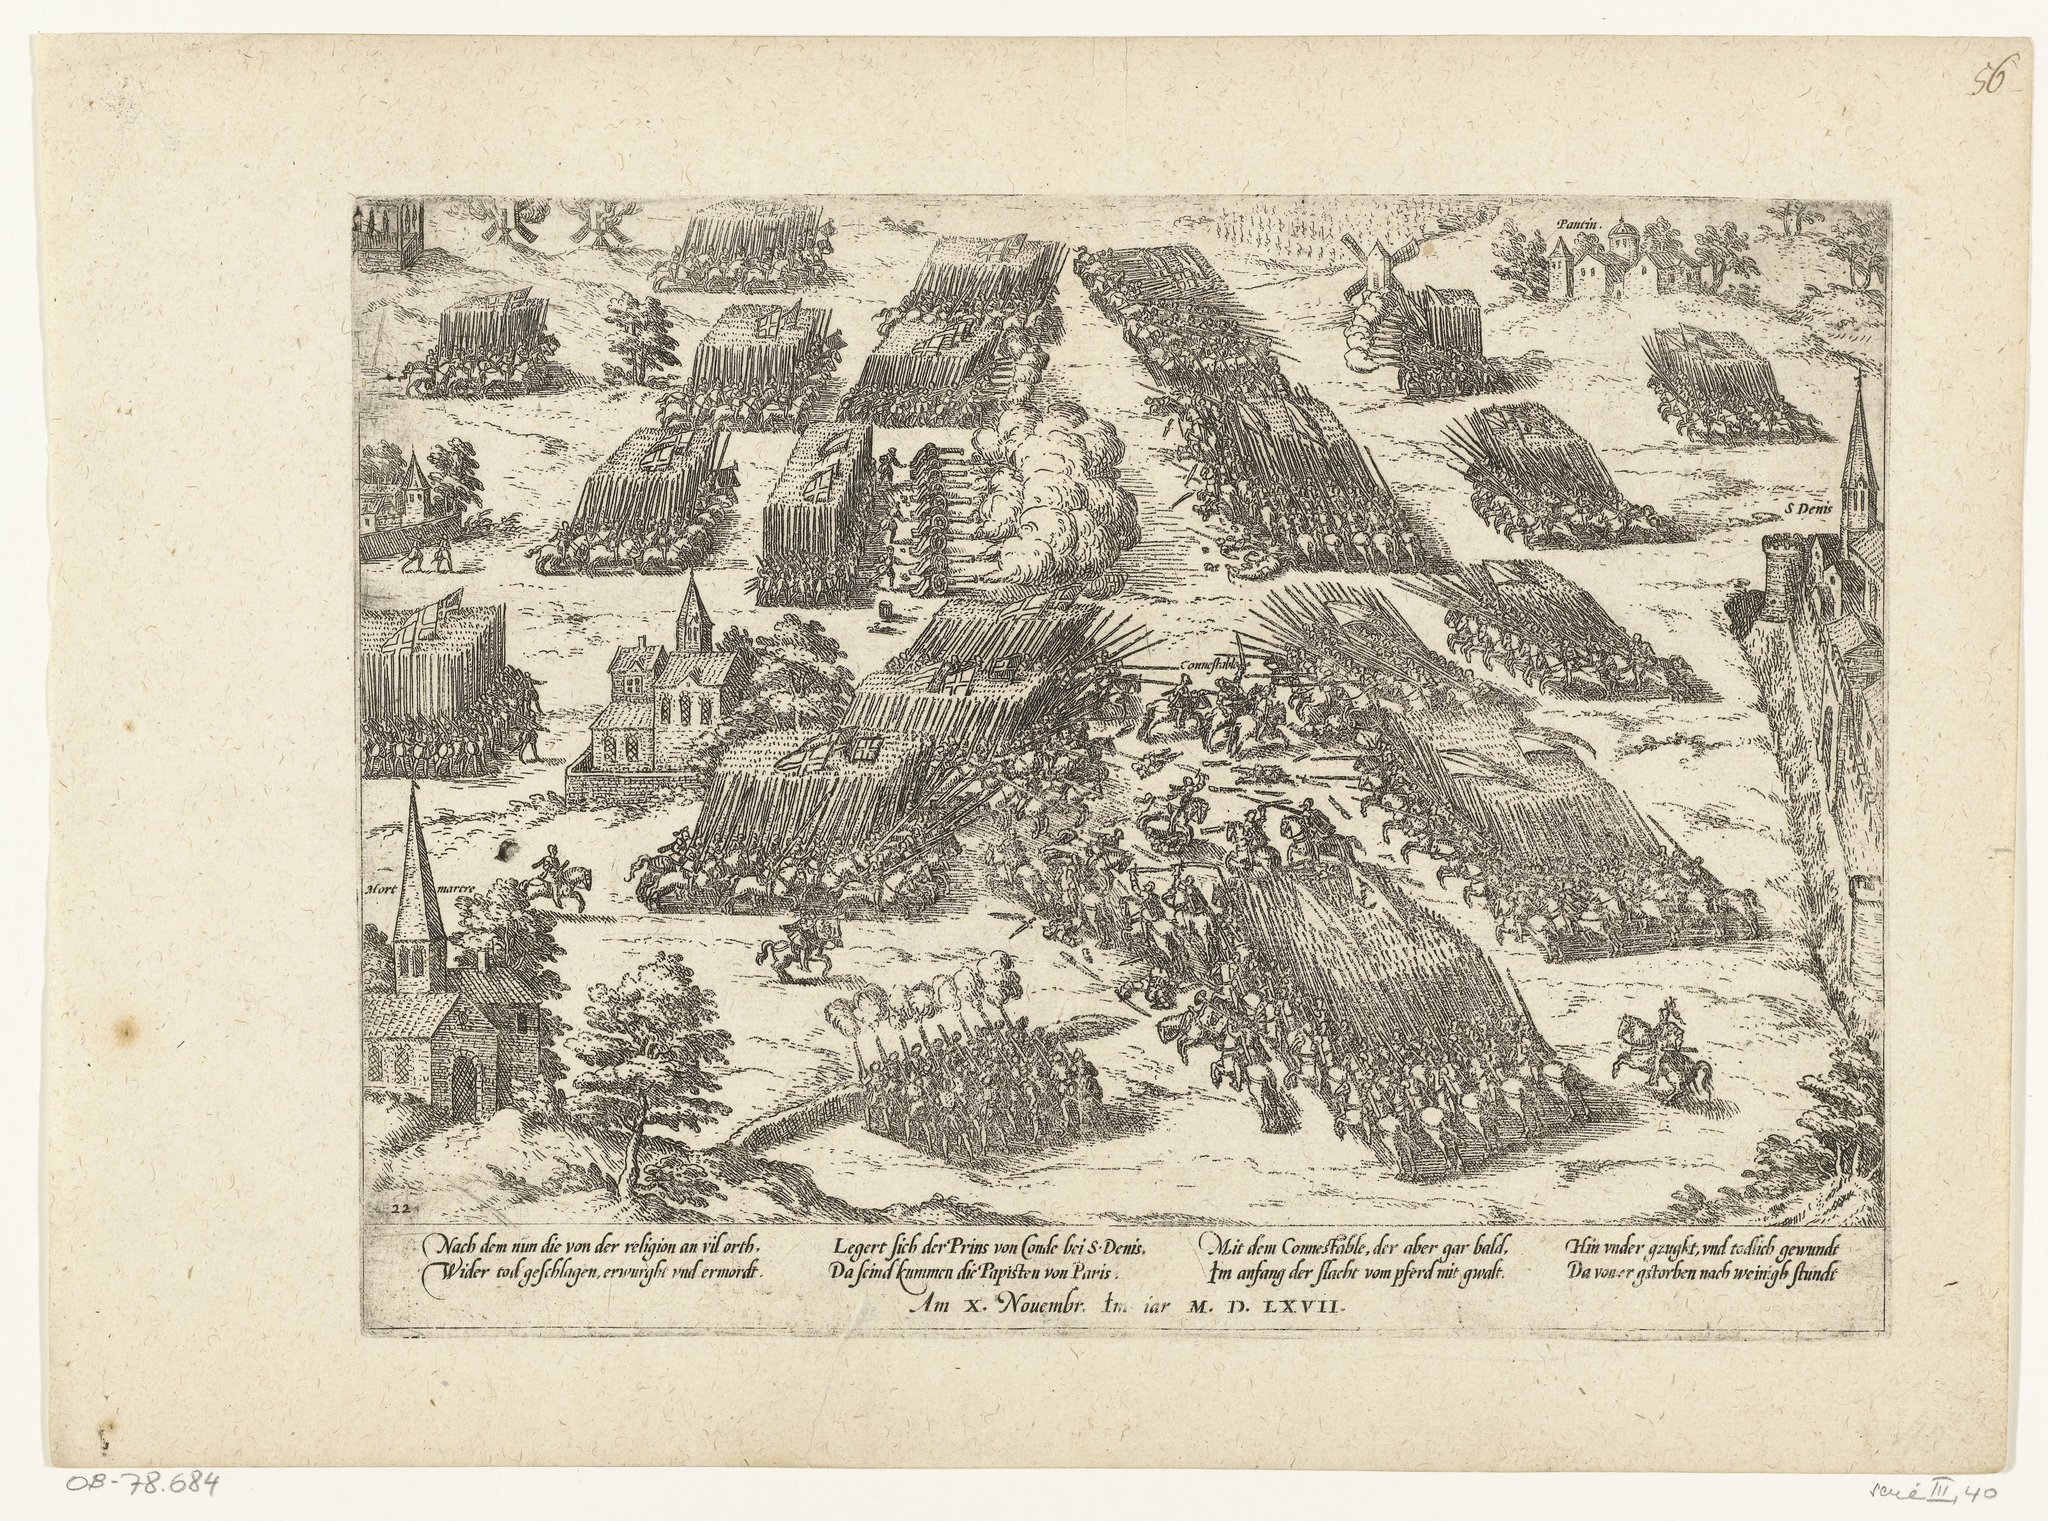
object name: history print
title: Slag bij Saint-Denis, 1567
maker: frans hogenberg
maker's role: print maker, publisher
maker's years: 1538-1590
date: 1565-1573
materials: paper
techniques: etching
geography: cologne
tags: battle, fighting in general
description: Gekopieerd naar de prent in: Jean Tortorel et Jacques Perrissin, Premier volume contenant quarante tableaux ou Histoires diverses qui sont memorables touchant les Guerres, Massacres et Troubles advenus en France en ces dernieres annees : le tout recueilly selon le tesmoignange de ceux qui y ont esté en personne et qui les ont veus : lesquels sont pourtraits à la vérité, Genève ca. 1570. Bibliotheek Rijksmuseum: 329 A 2, pl. 28.